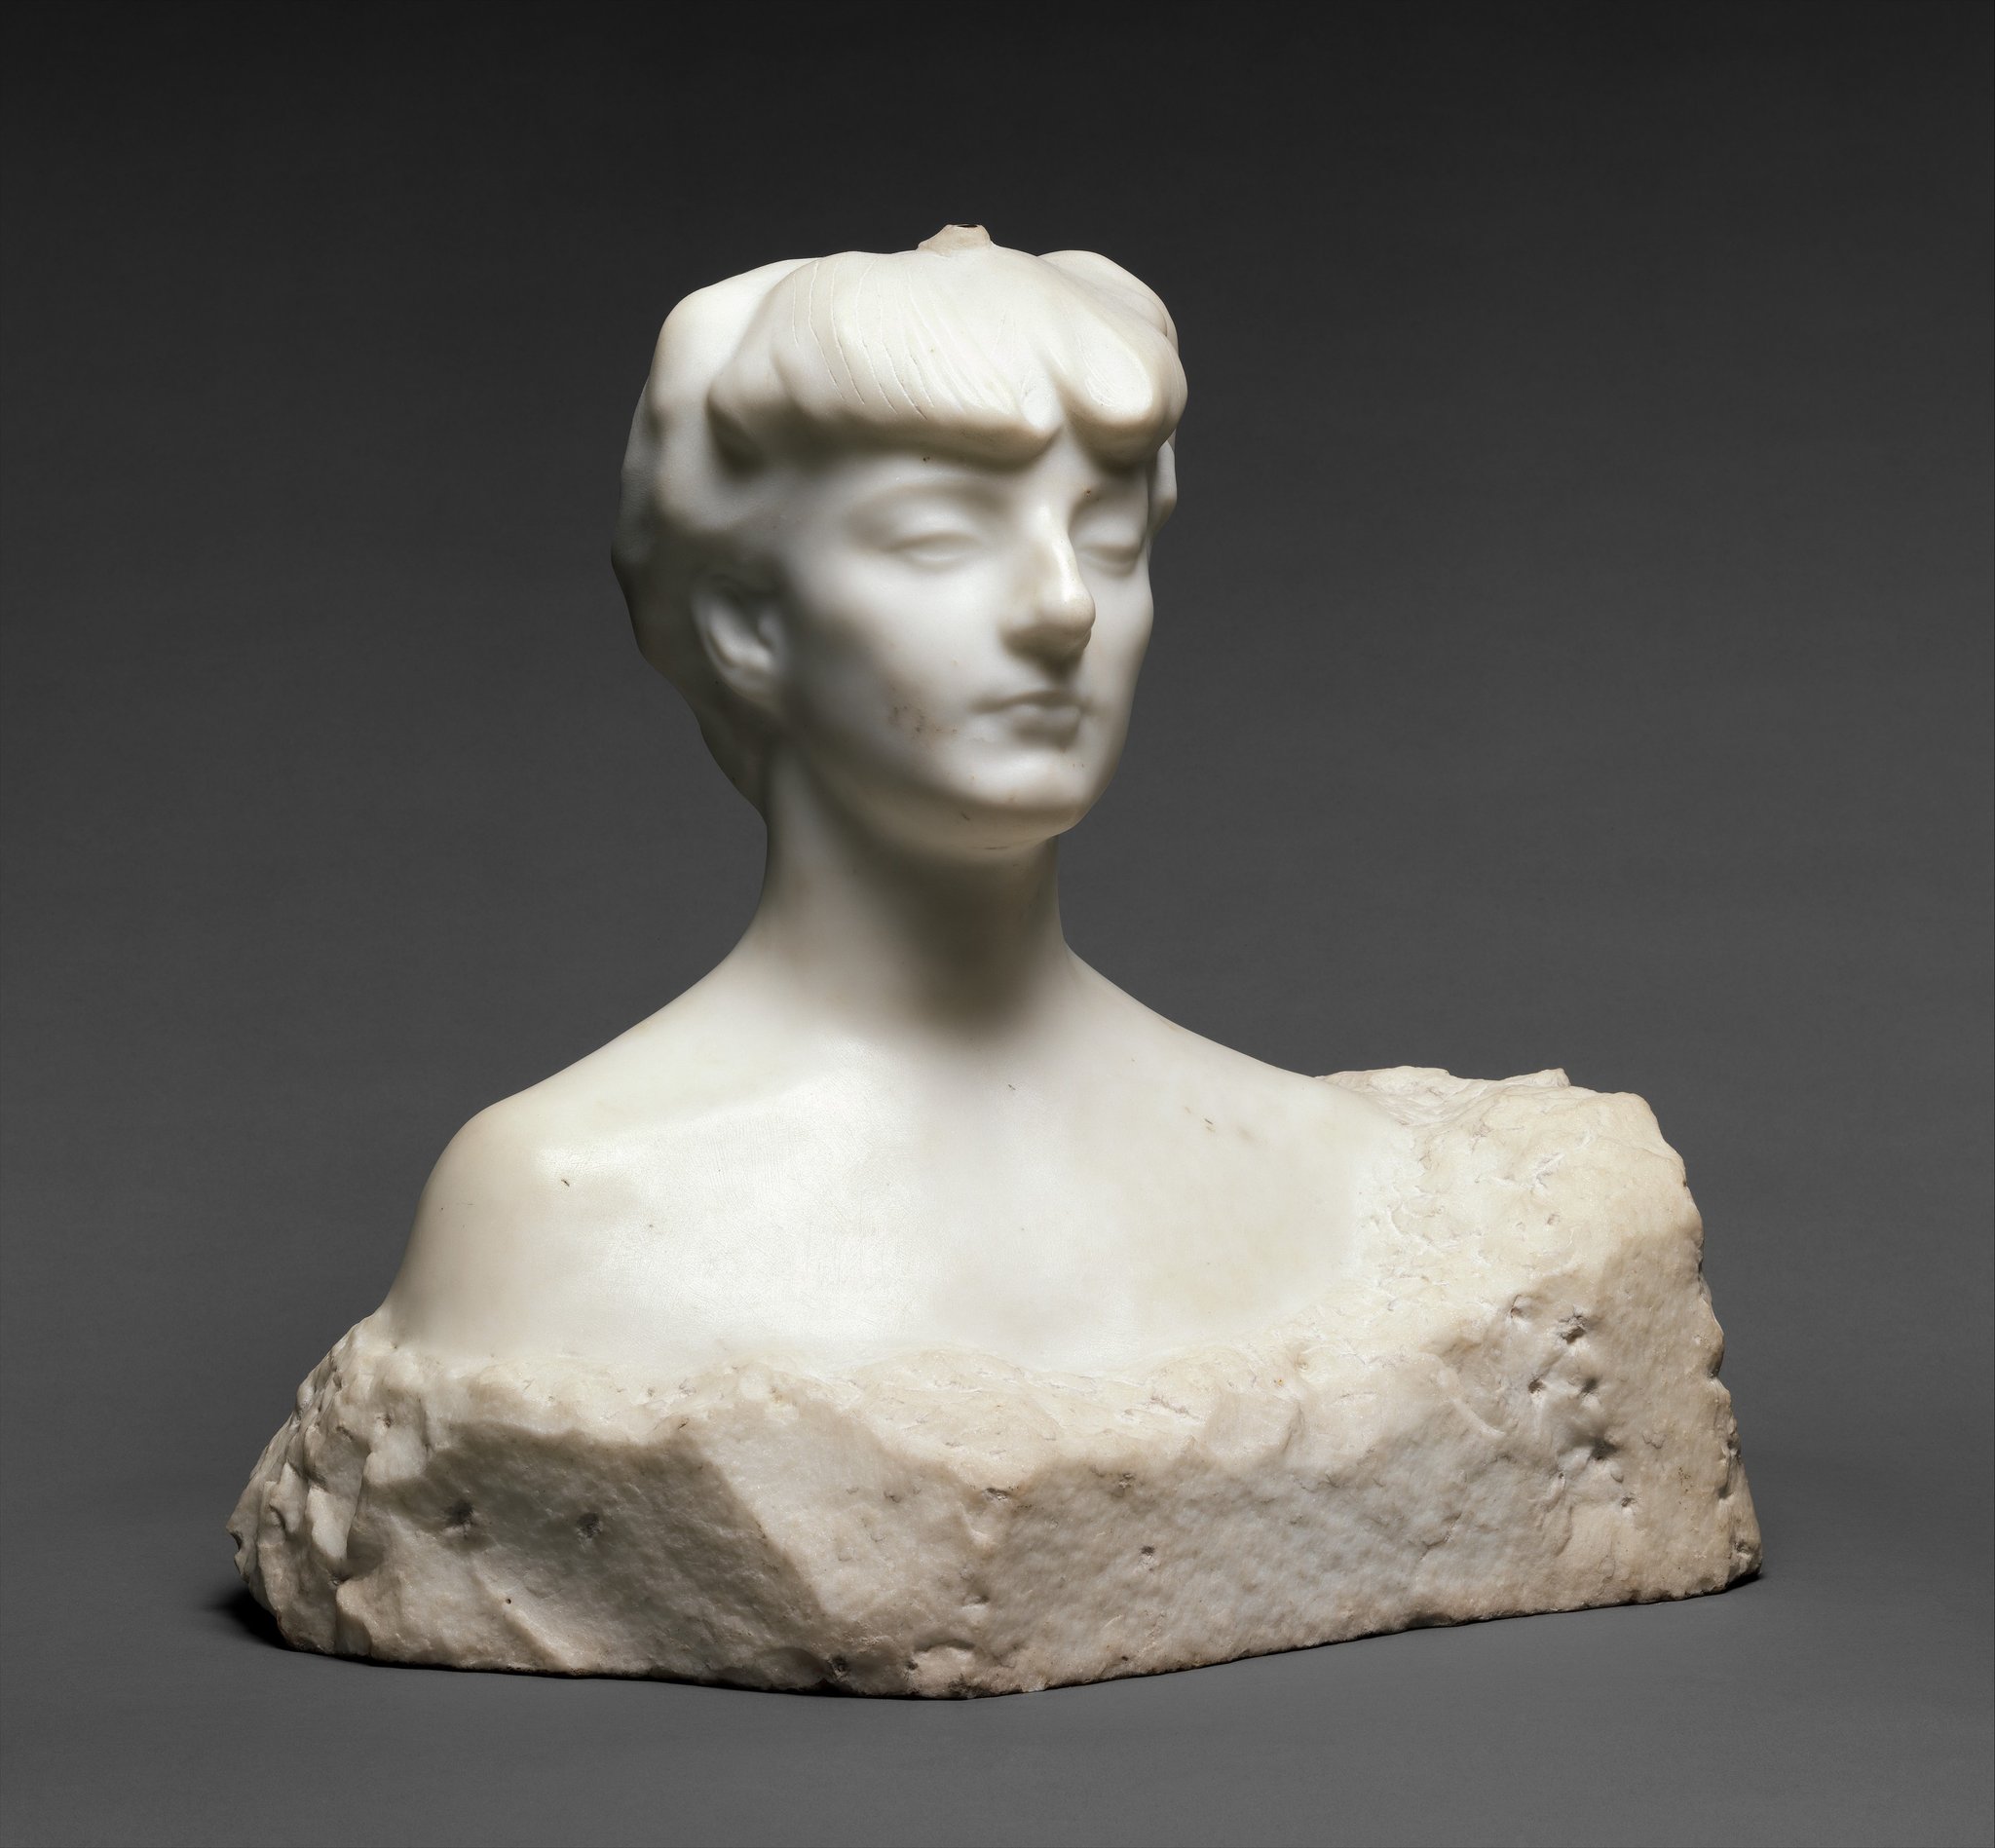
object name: bust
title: Madame X (Countess Anna-Elizabeth de Noailles)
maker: auguste rodin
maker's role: artist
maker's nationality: french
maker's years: 1840-1917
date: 1907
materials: marble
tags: portraits,women